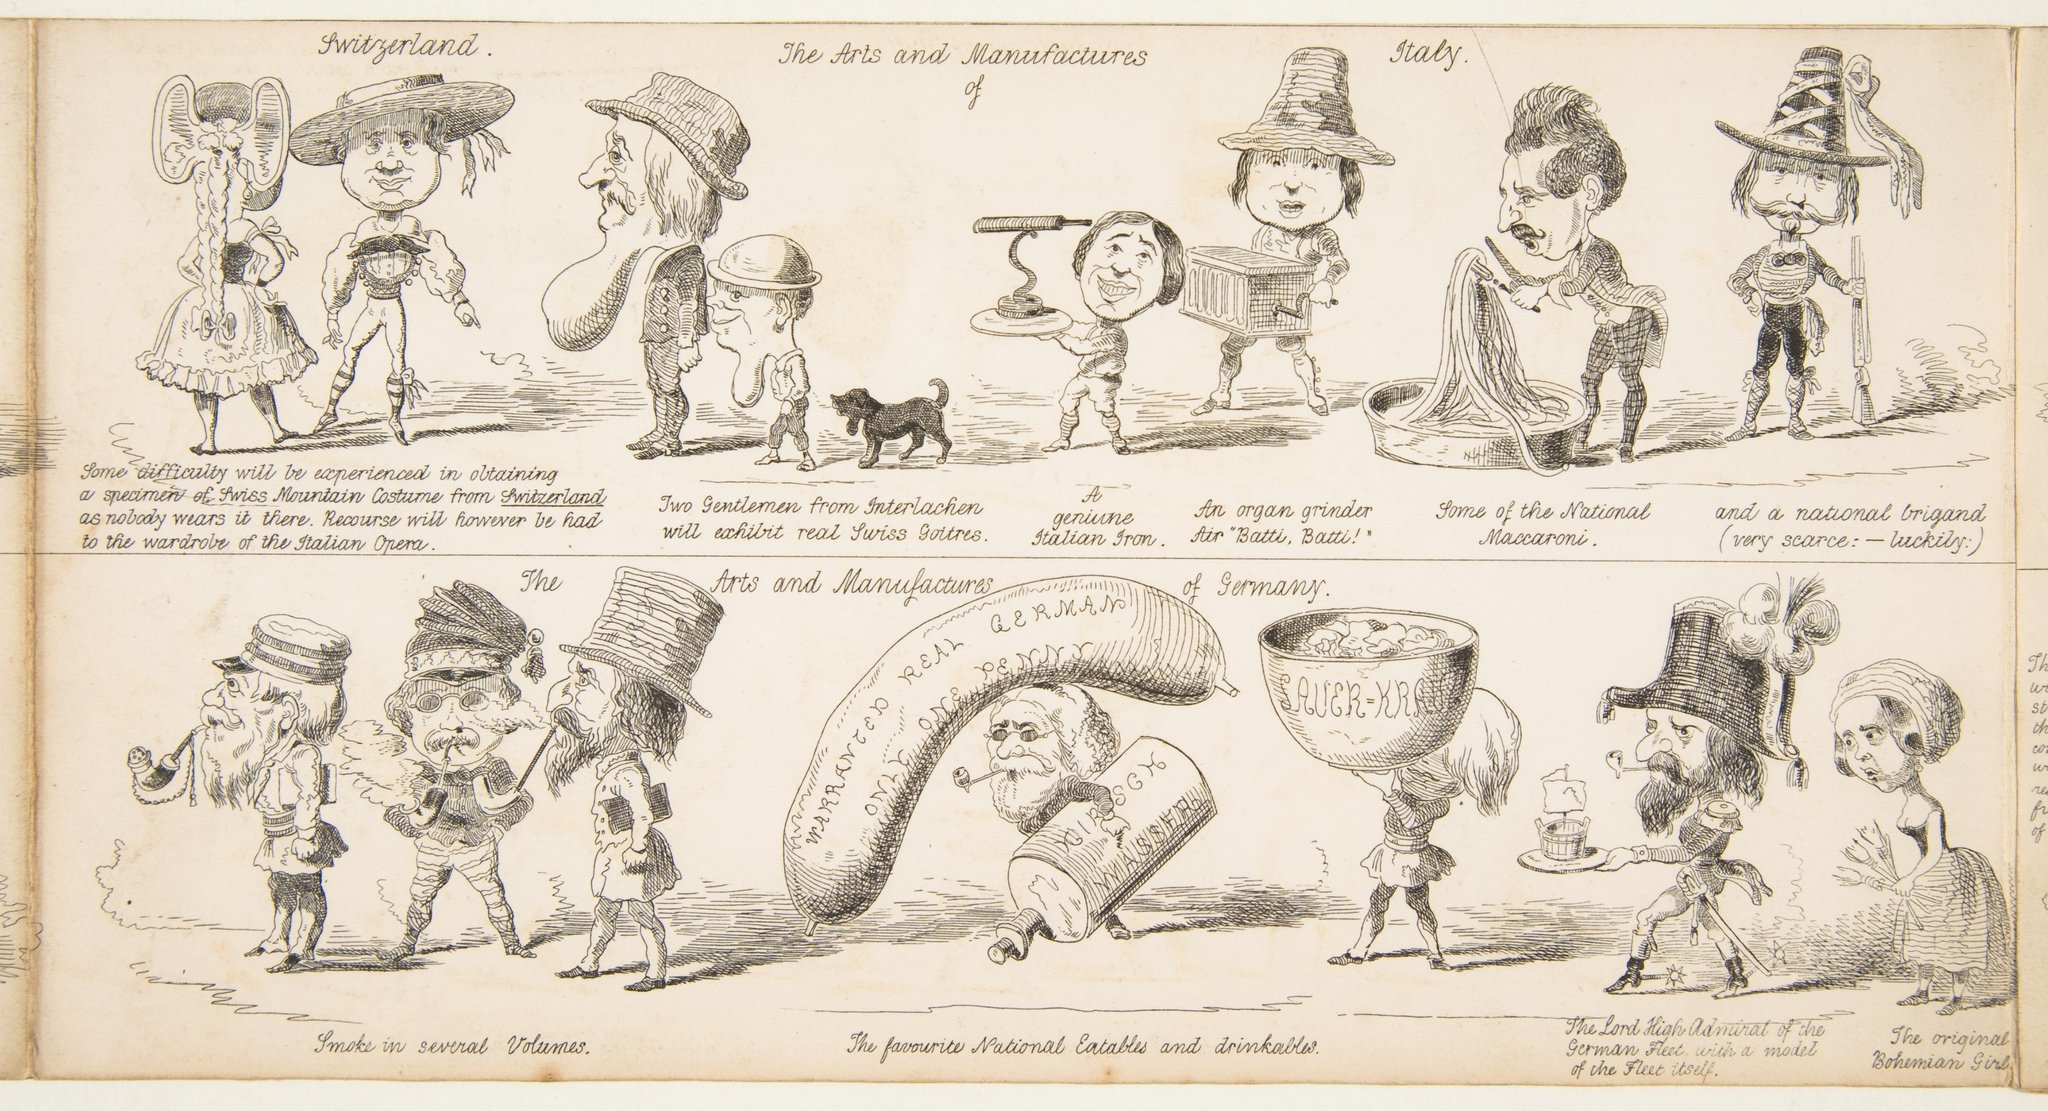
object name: print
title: The Great Exhibition "Wot is to Be", Probable Results of The Industry of All Nations in The Year '51, Showing What is to be Exhibited, Who is To Exhibit, in Short How Its All Going to Be Done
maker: george augustus sala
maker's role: author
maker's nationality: british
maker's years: 1828-1895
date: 1850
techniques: engraving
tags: satire,men,women,dogs